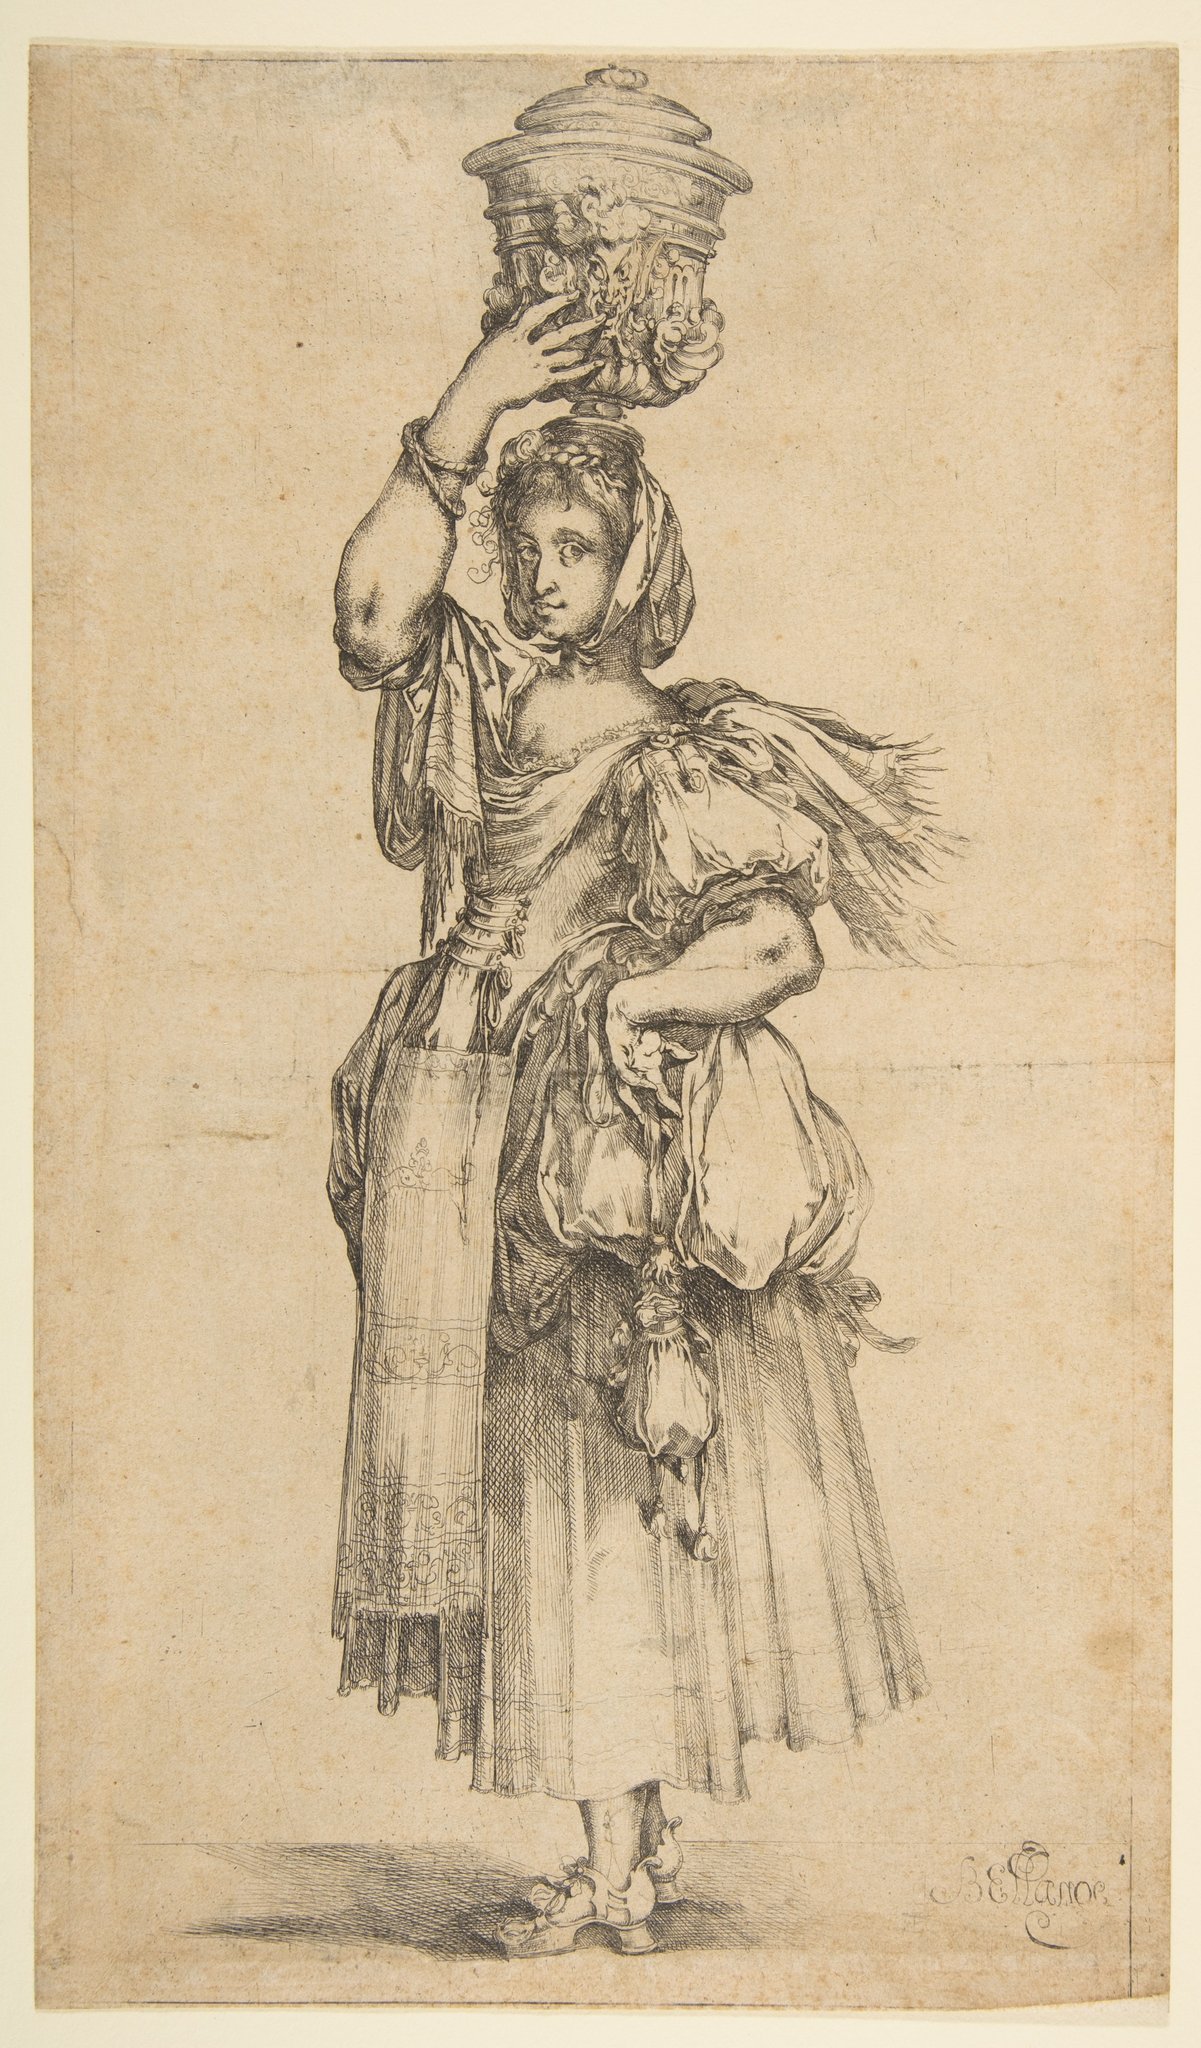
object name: print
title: Gardener, from "Hortulanae"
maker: jacques bellange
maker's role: artist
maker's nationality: french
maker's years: 1575-1616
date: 1575-1616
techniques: etching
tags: women,gardeners